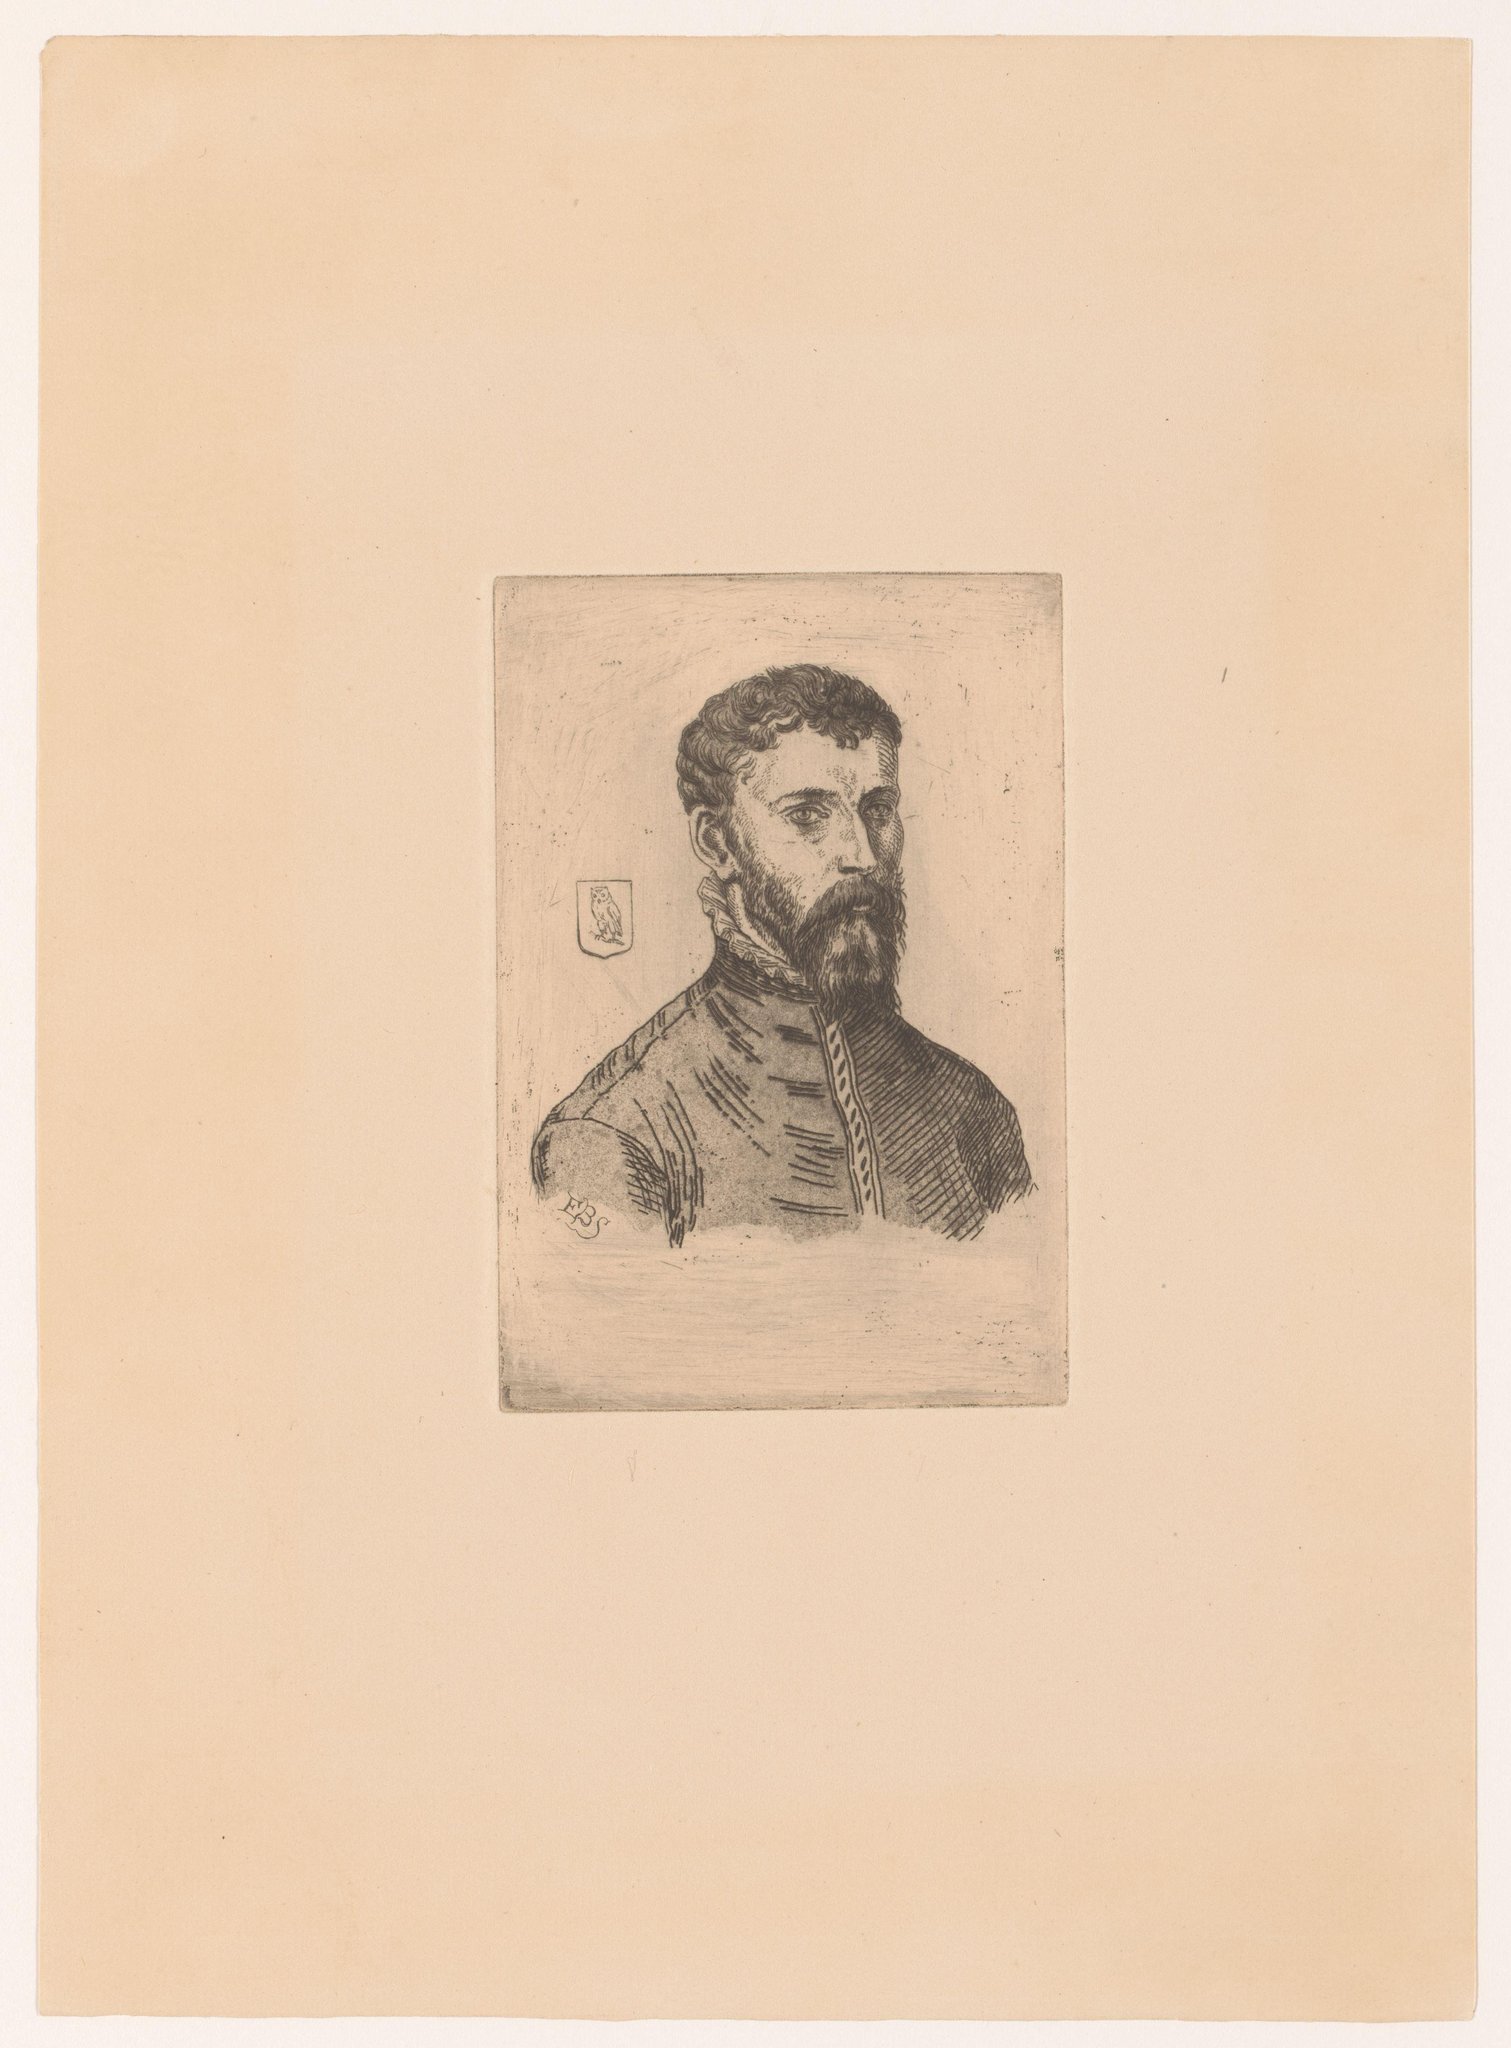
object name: print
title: Portret van Herri met de Bles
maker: edgar alfred baes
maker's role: print maker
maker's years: 1837-1909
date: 1847-1909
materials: paper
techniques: etching, intaglio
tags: print maker, herri met de bles, portrait, self-portrait of painter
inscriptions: collector's mark: Lugt 2228